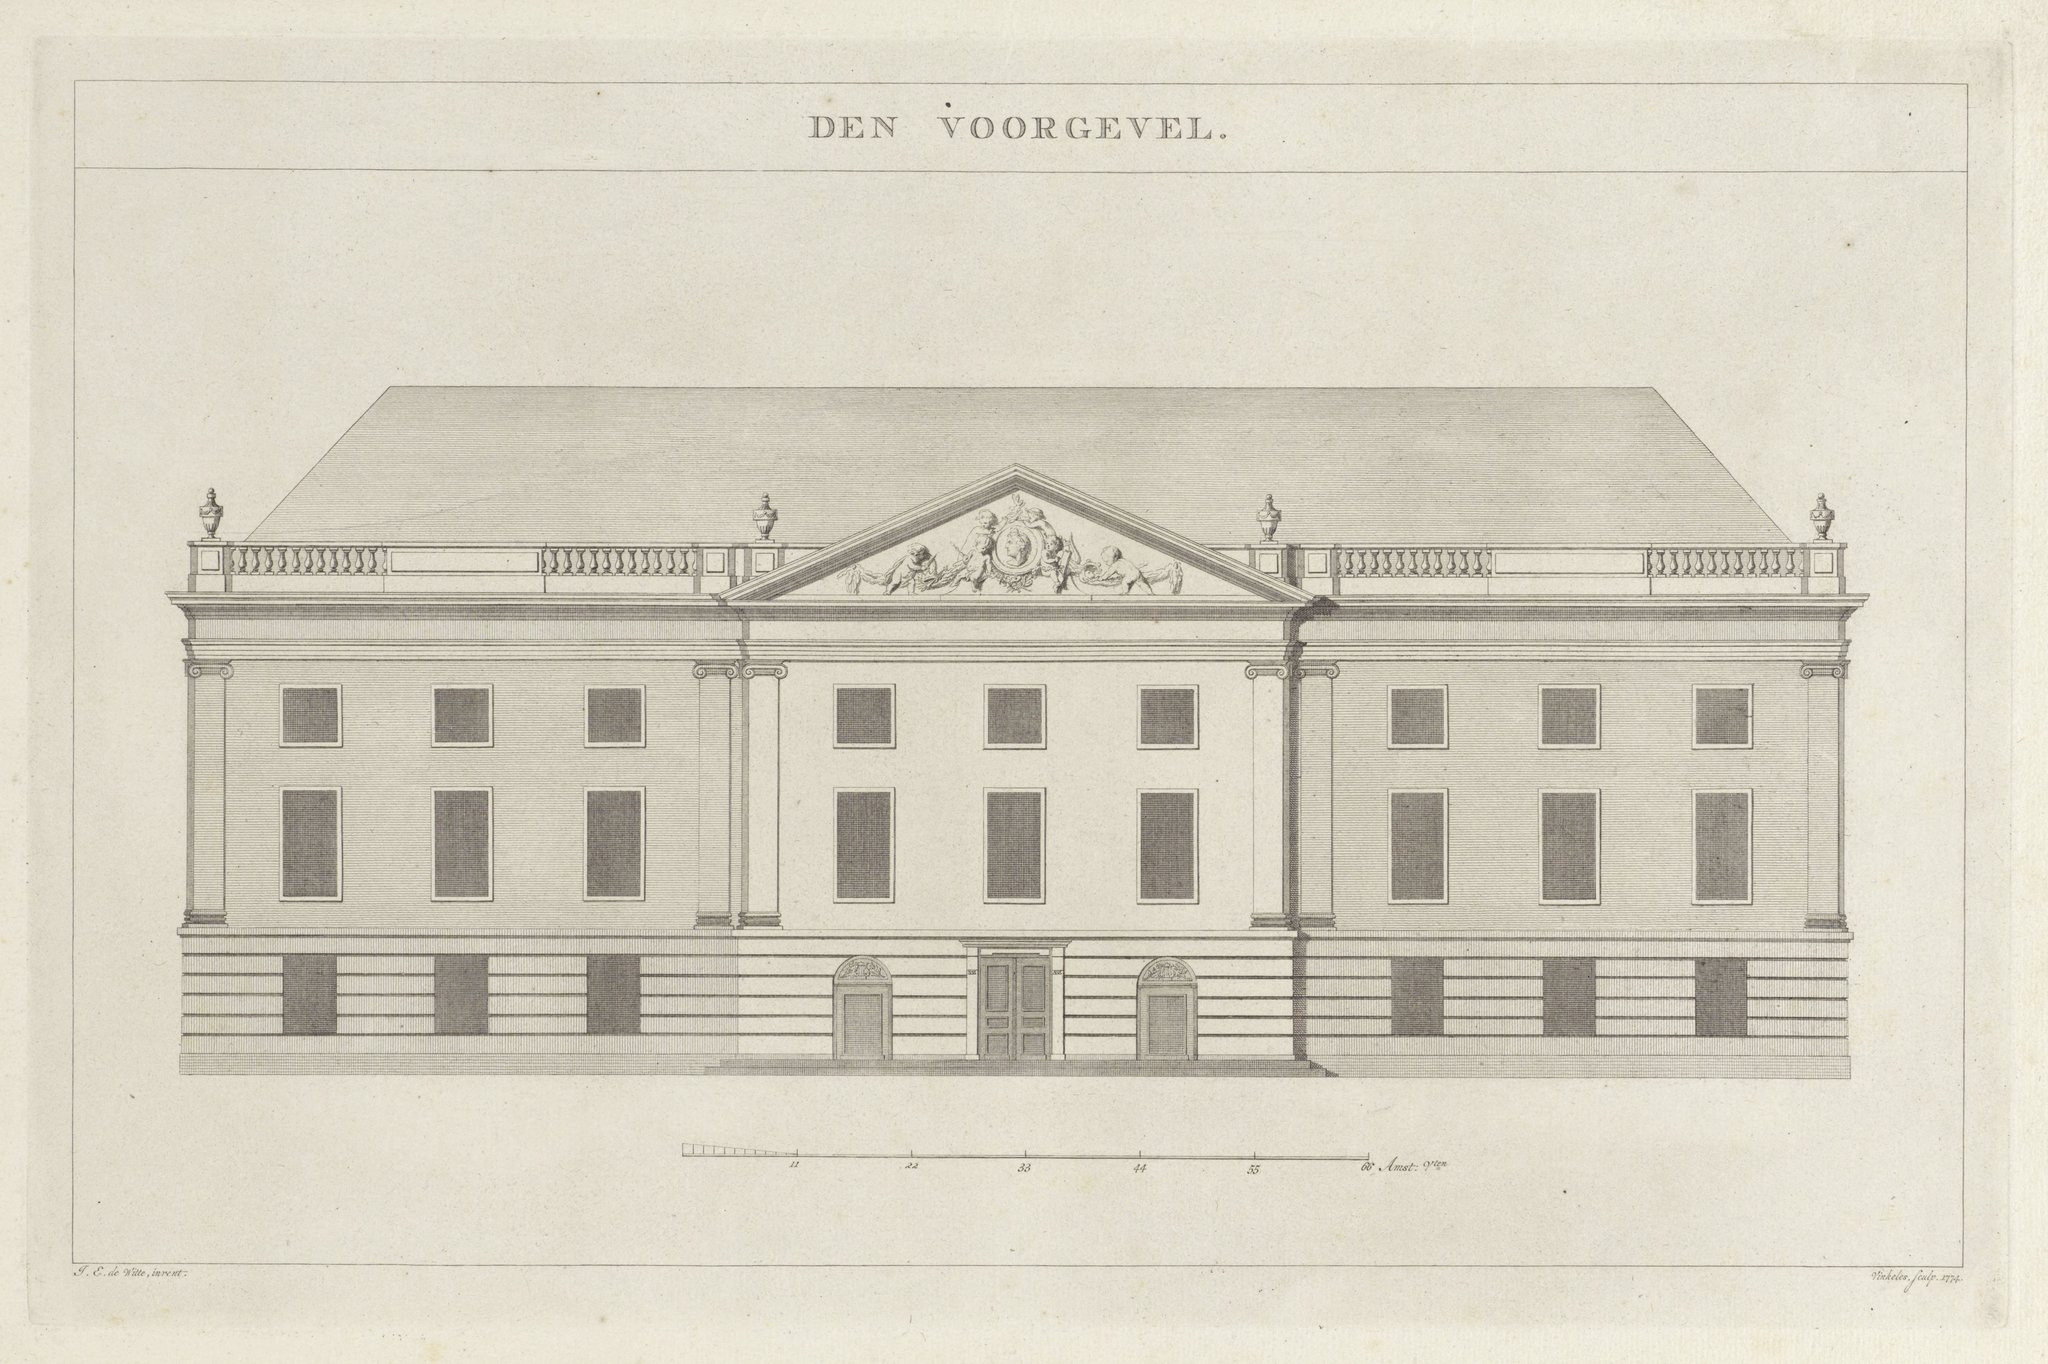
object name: print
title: Den Voorgevel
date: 1774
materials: paper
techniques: etching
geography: amsterdam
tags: theatre (building), amsterdam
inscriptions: collector's mark: Lugt 2228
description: Illustratie voor: Witte, Jacob Eduard de. Afbeeldingen van den schouwburg te Amsterdam. Amsterdam: Johannes Smit, 1774.